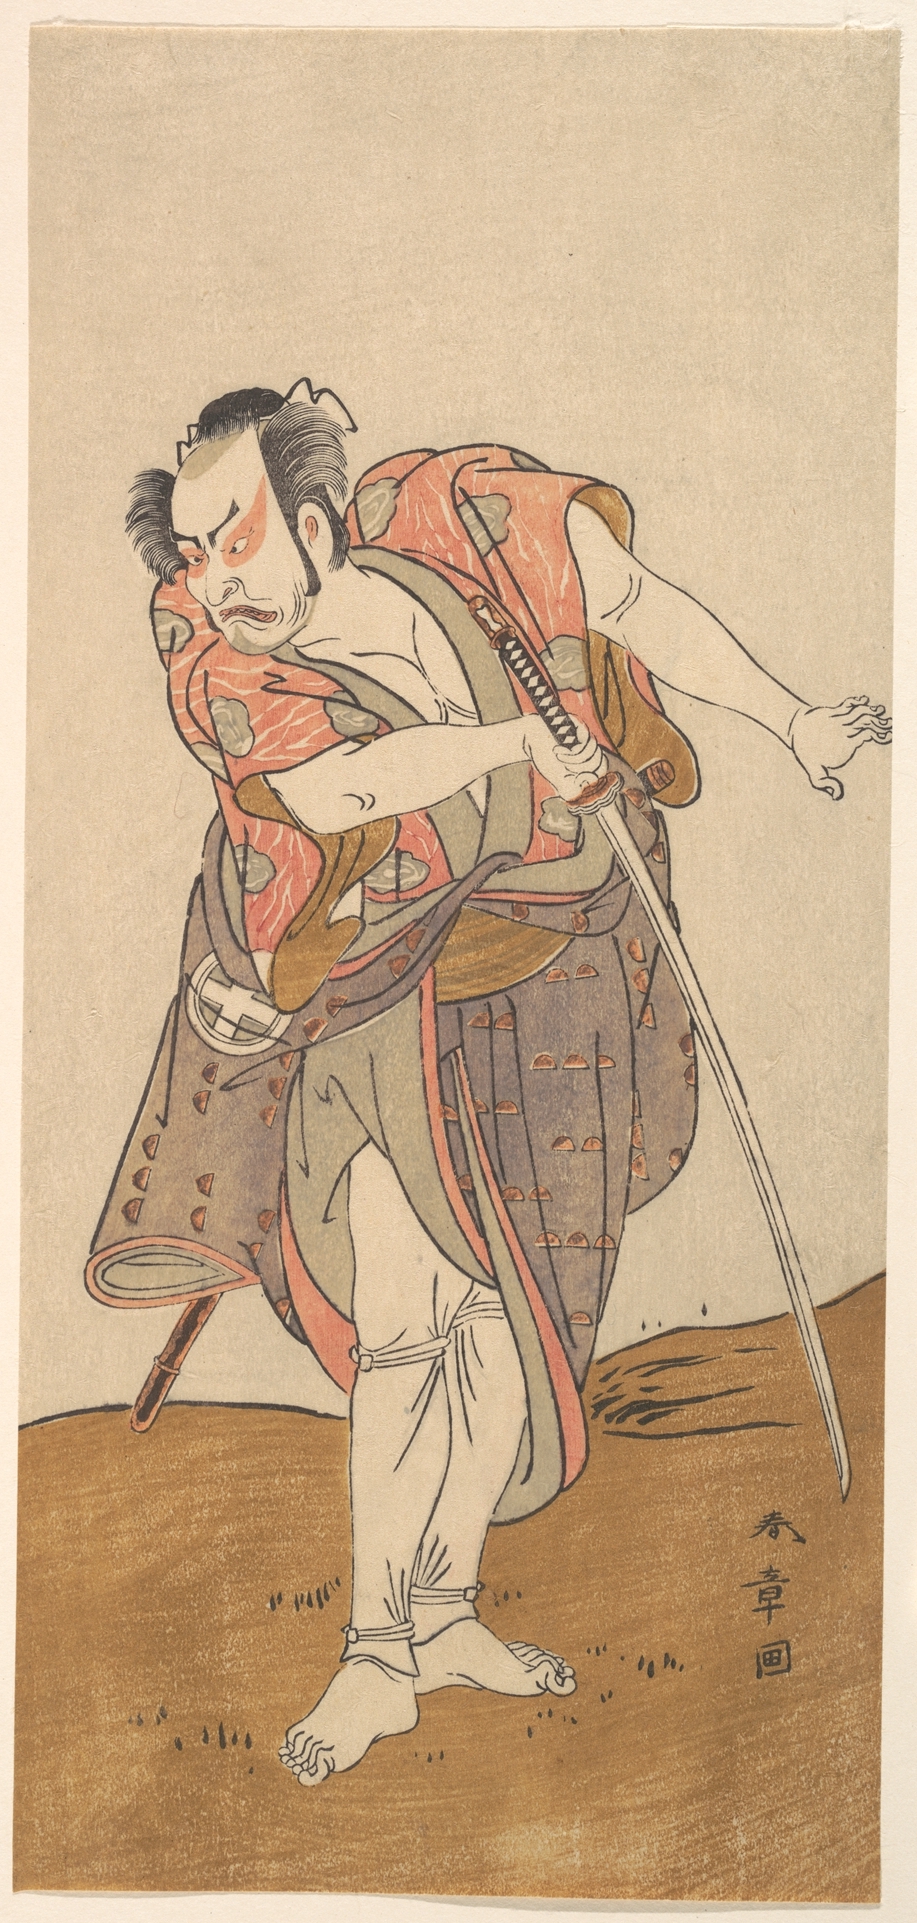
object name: woodblock print nishiki e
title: The Actor Otani Hiroyemon III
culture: japanese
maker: katsukawa shunshō 勝川春章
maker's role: artist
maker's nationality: japanese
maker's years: 1726-1792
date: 1726-1792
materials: ink, paper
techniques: nishiki e, woodblock print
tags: swords,men,actors